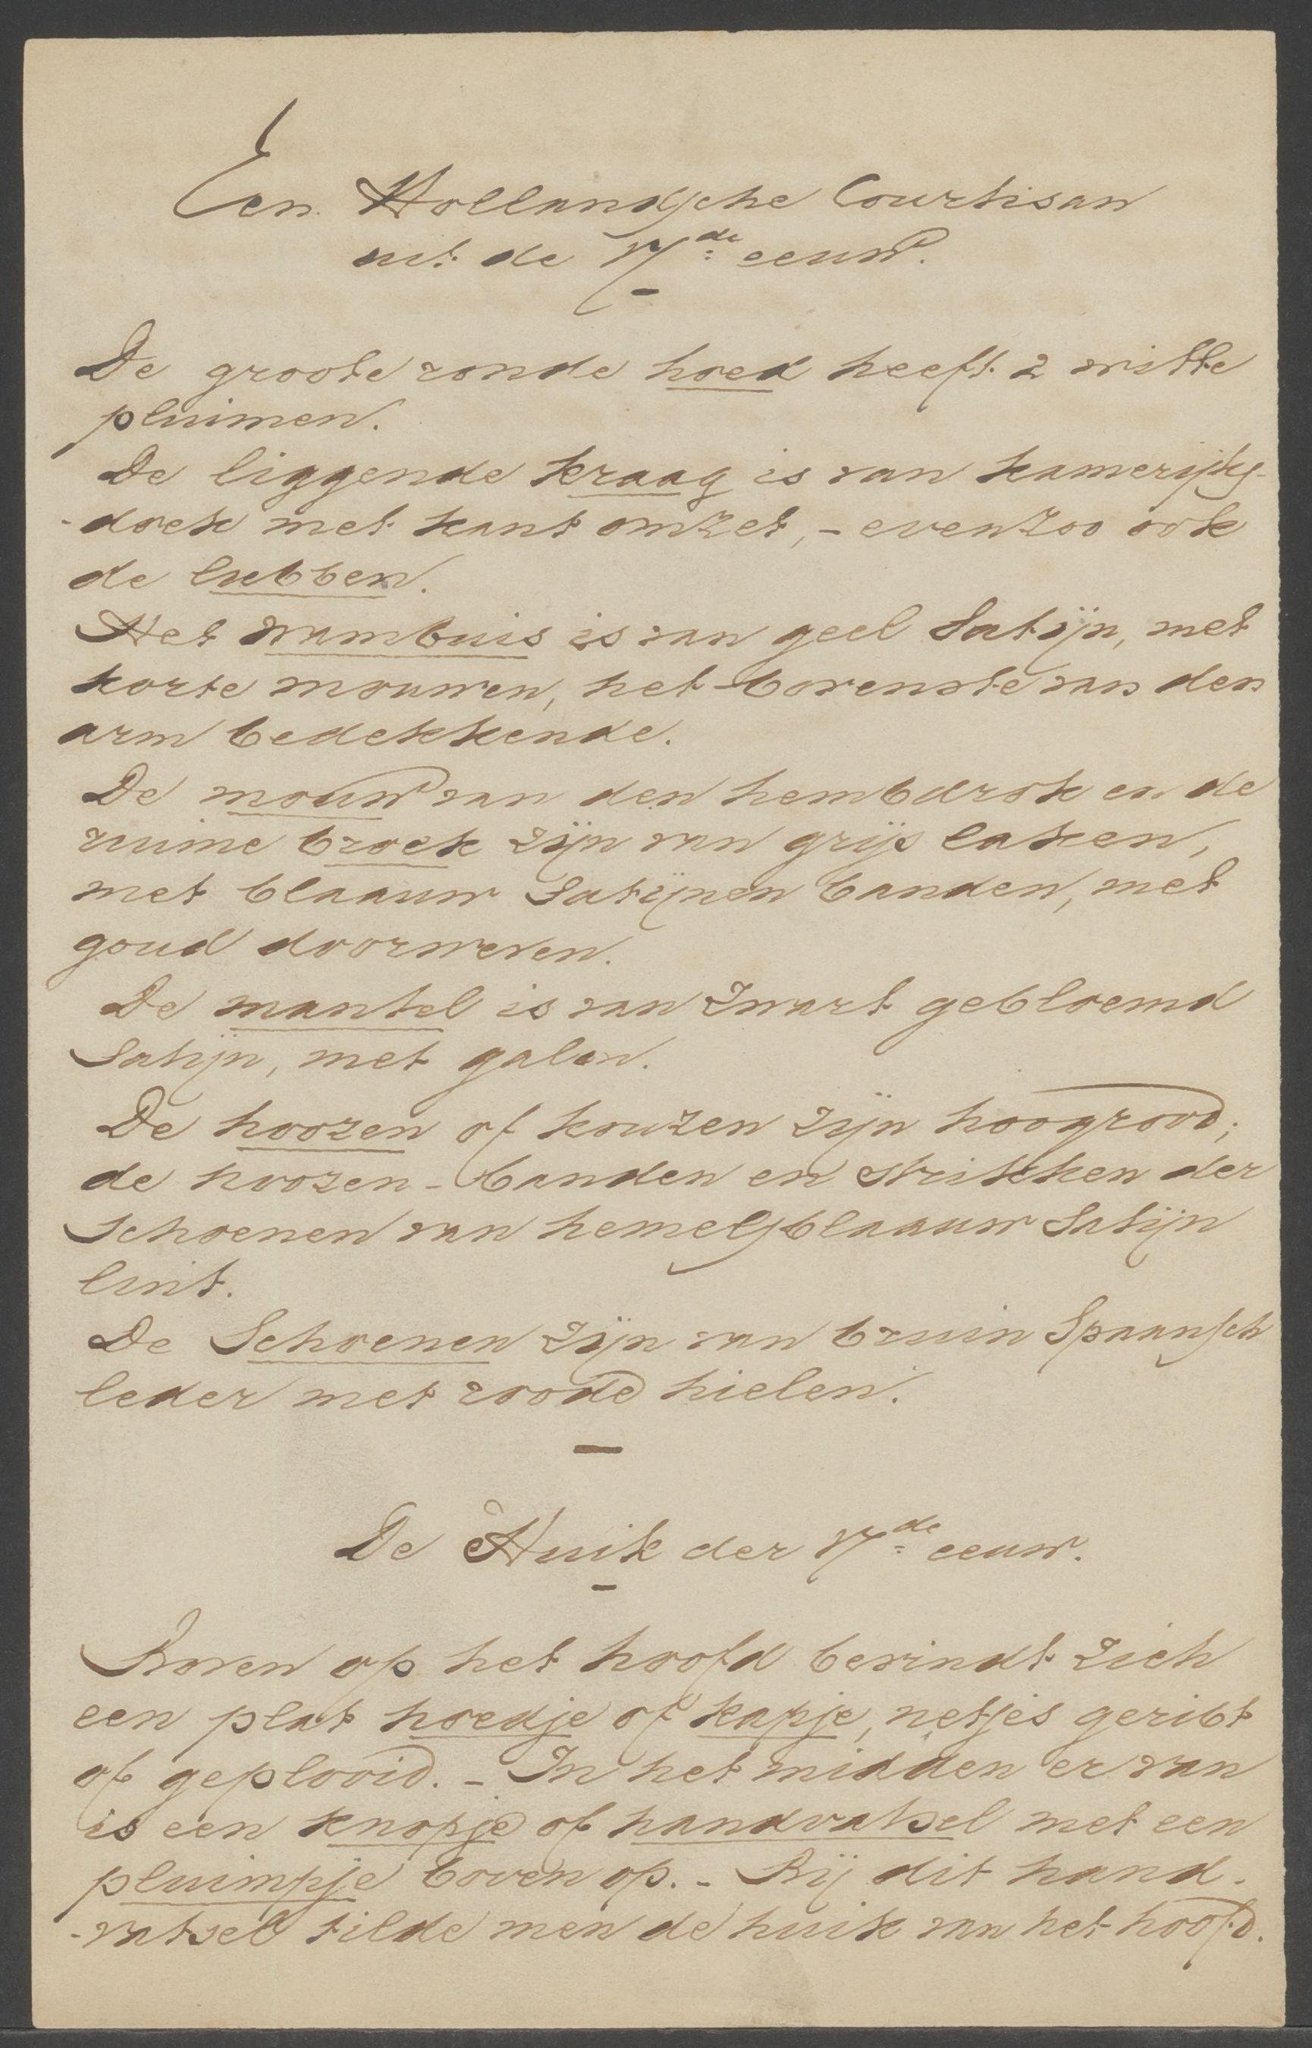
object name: text sheet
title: Uitleg van verschillende kledingstukken uit de zeventiende eeuw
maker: Anonymous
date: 1800-1899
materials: ink, paper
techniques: pen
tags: cape (huik) (+ women's clothes), historical costume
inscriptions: stamp, collector's mark: Lugt 1641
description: Uitleg van verschillende kledingstukken uit de zeventiende eeuw. Eerst een beschrijving van de kleding van een courtisane en beschrijving van haar hoed, kraag, wambuis, mouwen, mantel, hozen en schoenen. Onderwerpsrubrieken binnen de Atlas Zeden en Gewoonten: Zeden en Gewoonten in Engeren Zin, De Kleeding, Kleederdrachten (tijdvakken), Het begin der 17de eeuw. (De Fransche mode).